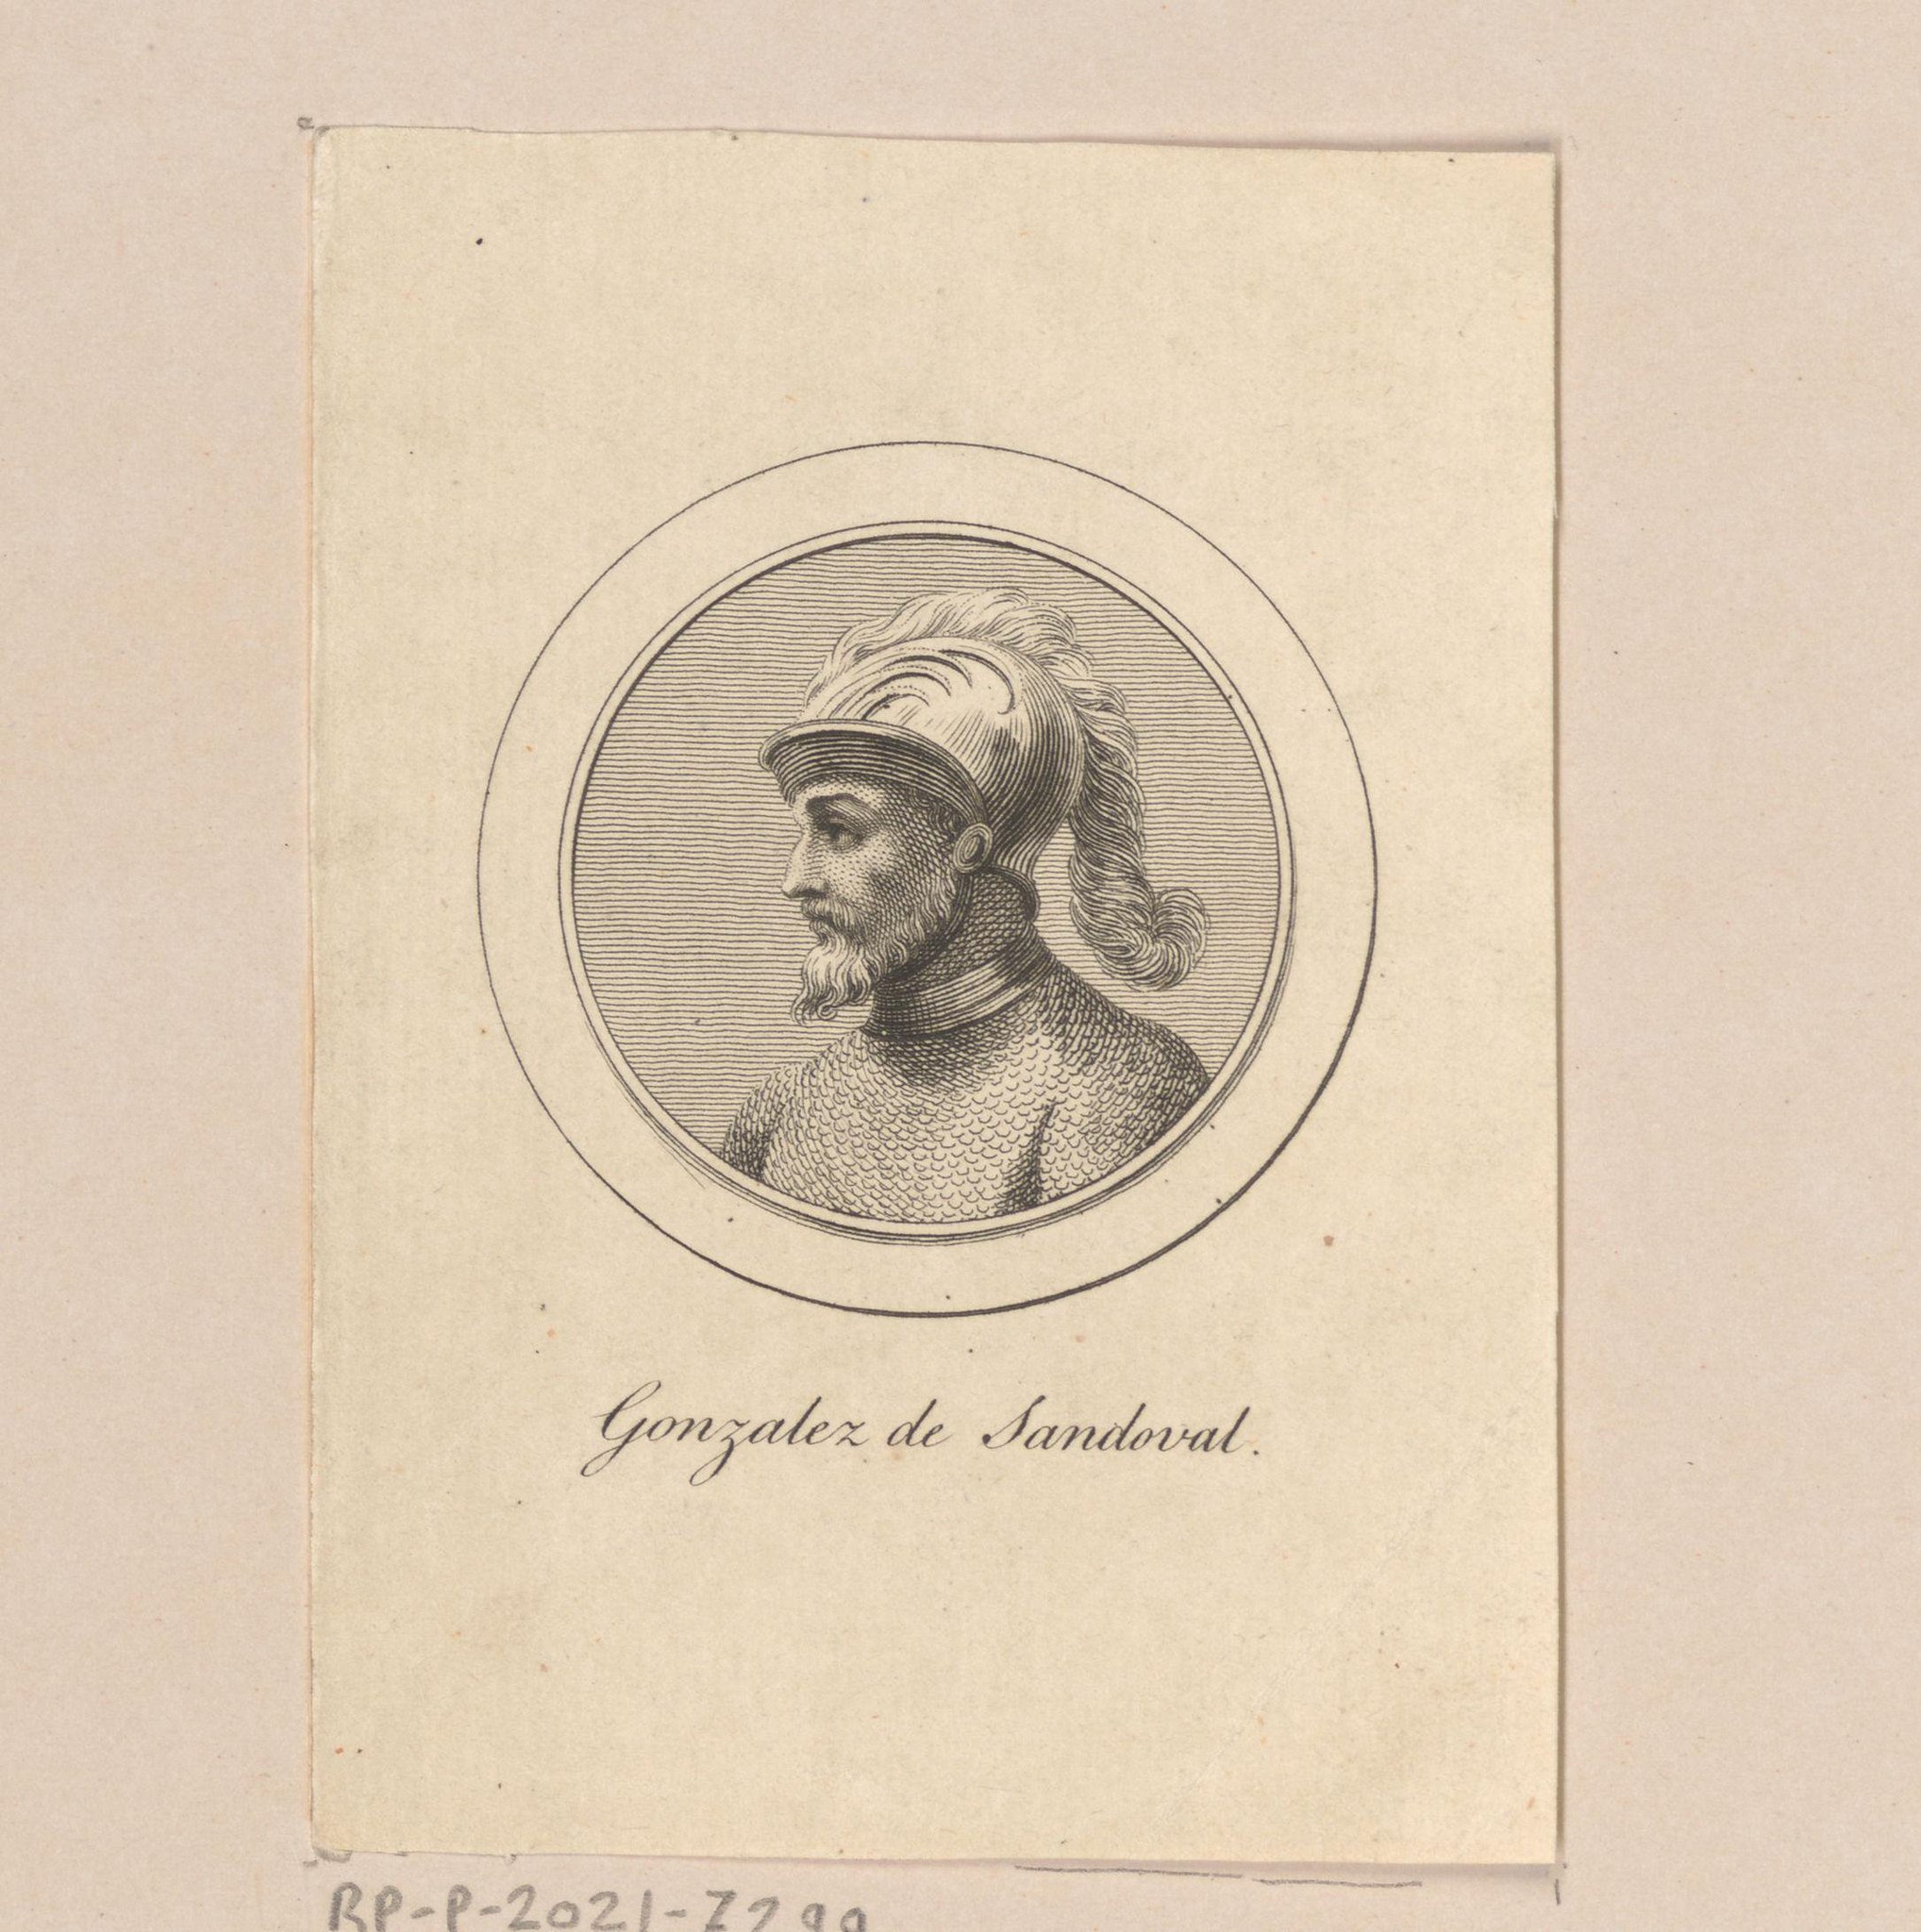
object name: print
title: Portret van Gonzalo de Sandoval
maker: Anonymous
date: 1787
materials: paper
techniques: engraving, etching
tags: historical persons, explorer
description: Deze prent maakt deel uit van een grotere prent met vier portretten die later is verknipt. Prent waarschijnlijk uit: Saverio Clavigero, Francesco. The history of Mexico: collected from Spanish and Mexican historians (...). Londen: G.G.J. en J. Robinson, 1787.